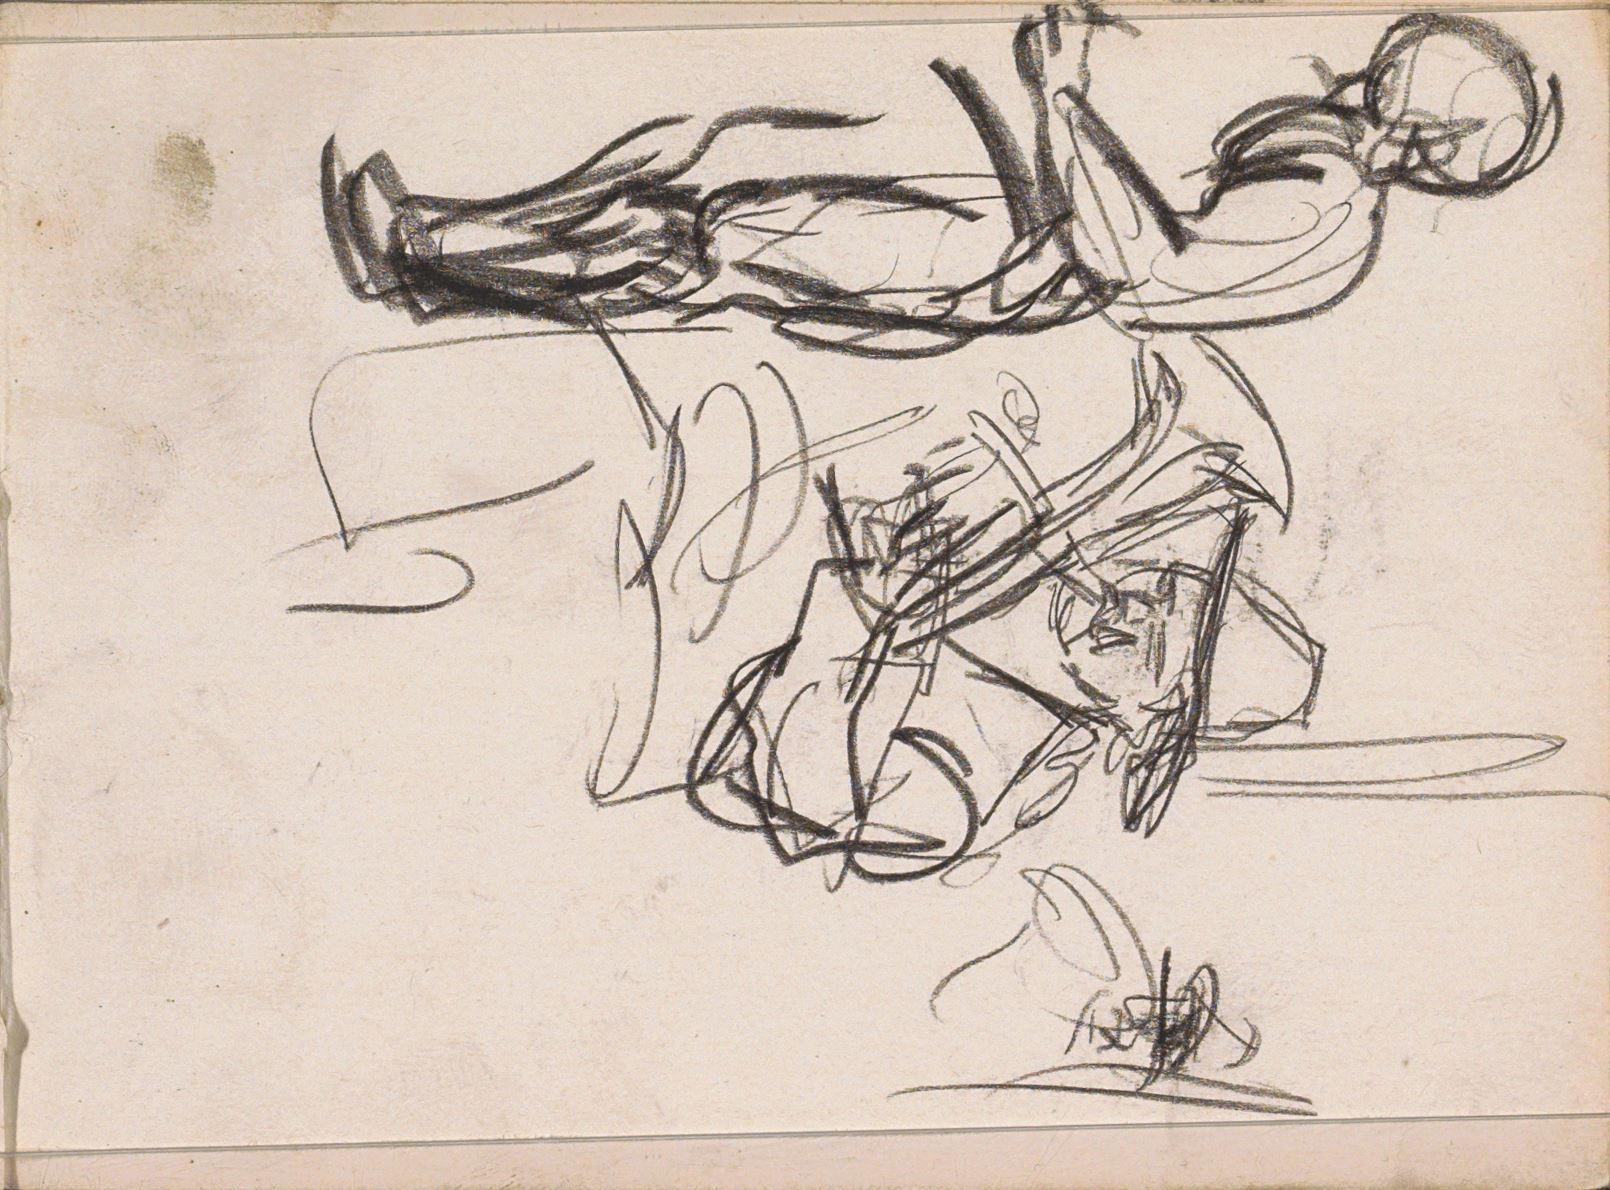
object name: sketchbook leaf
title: Staande figuur en een tubaspeler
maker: isaac israels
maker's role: draughtsman, painter, print maker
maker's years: 1865-1934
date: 1875-1934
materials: chalk, paper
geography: paris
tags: horn, trumpet, cornet, trombone, tuba (+ artist at work), the (nude) human figure; 'corpo humano' (ripa) (+ standing)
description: Pagina 14 uit schetsboek XLV met 85 pagina's.